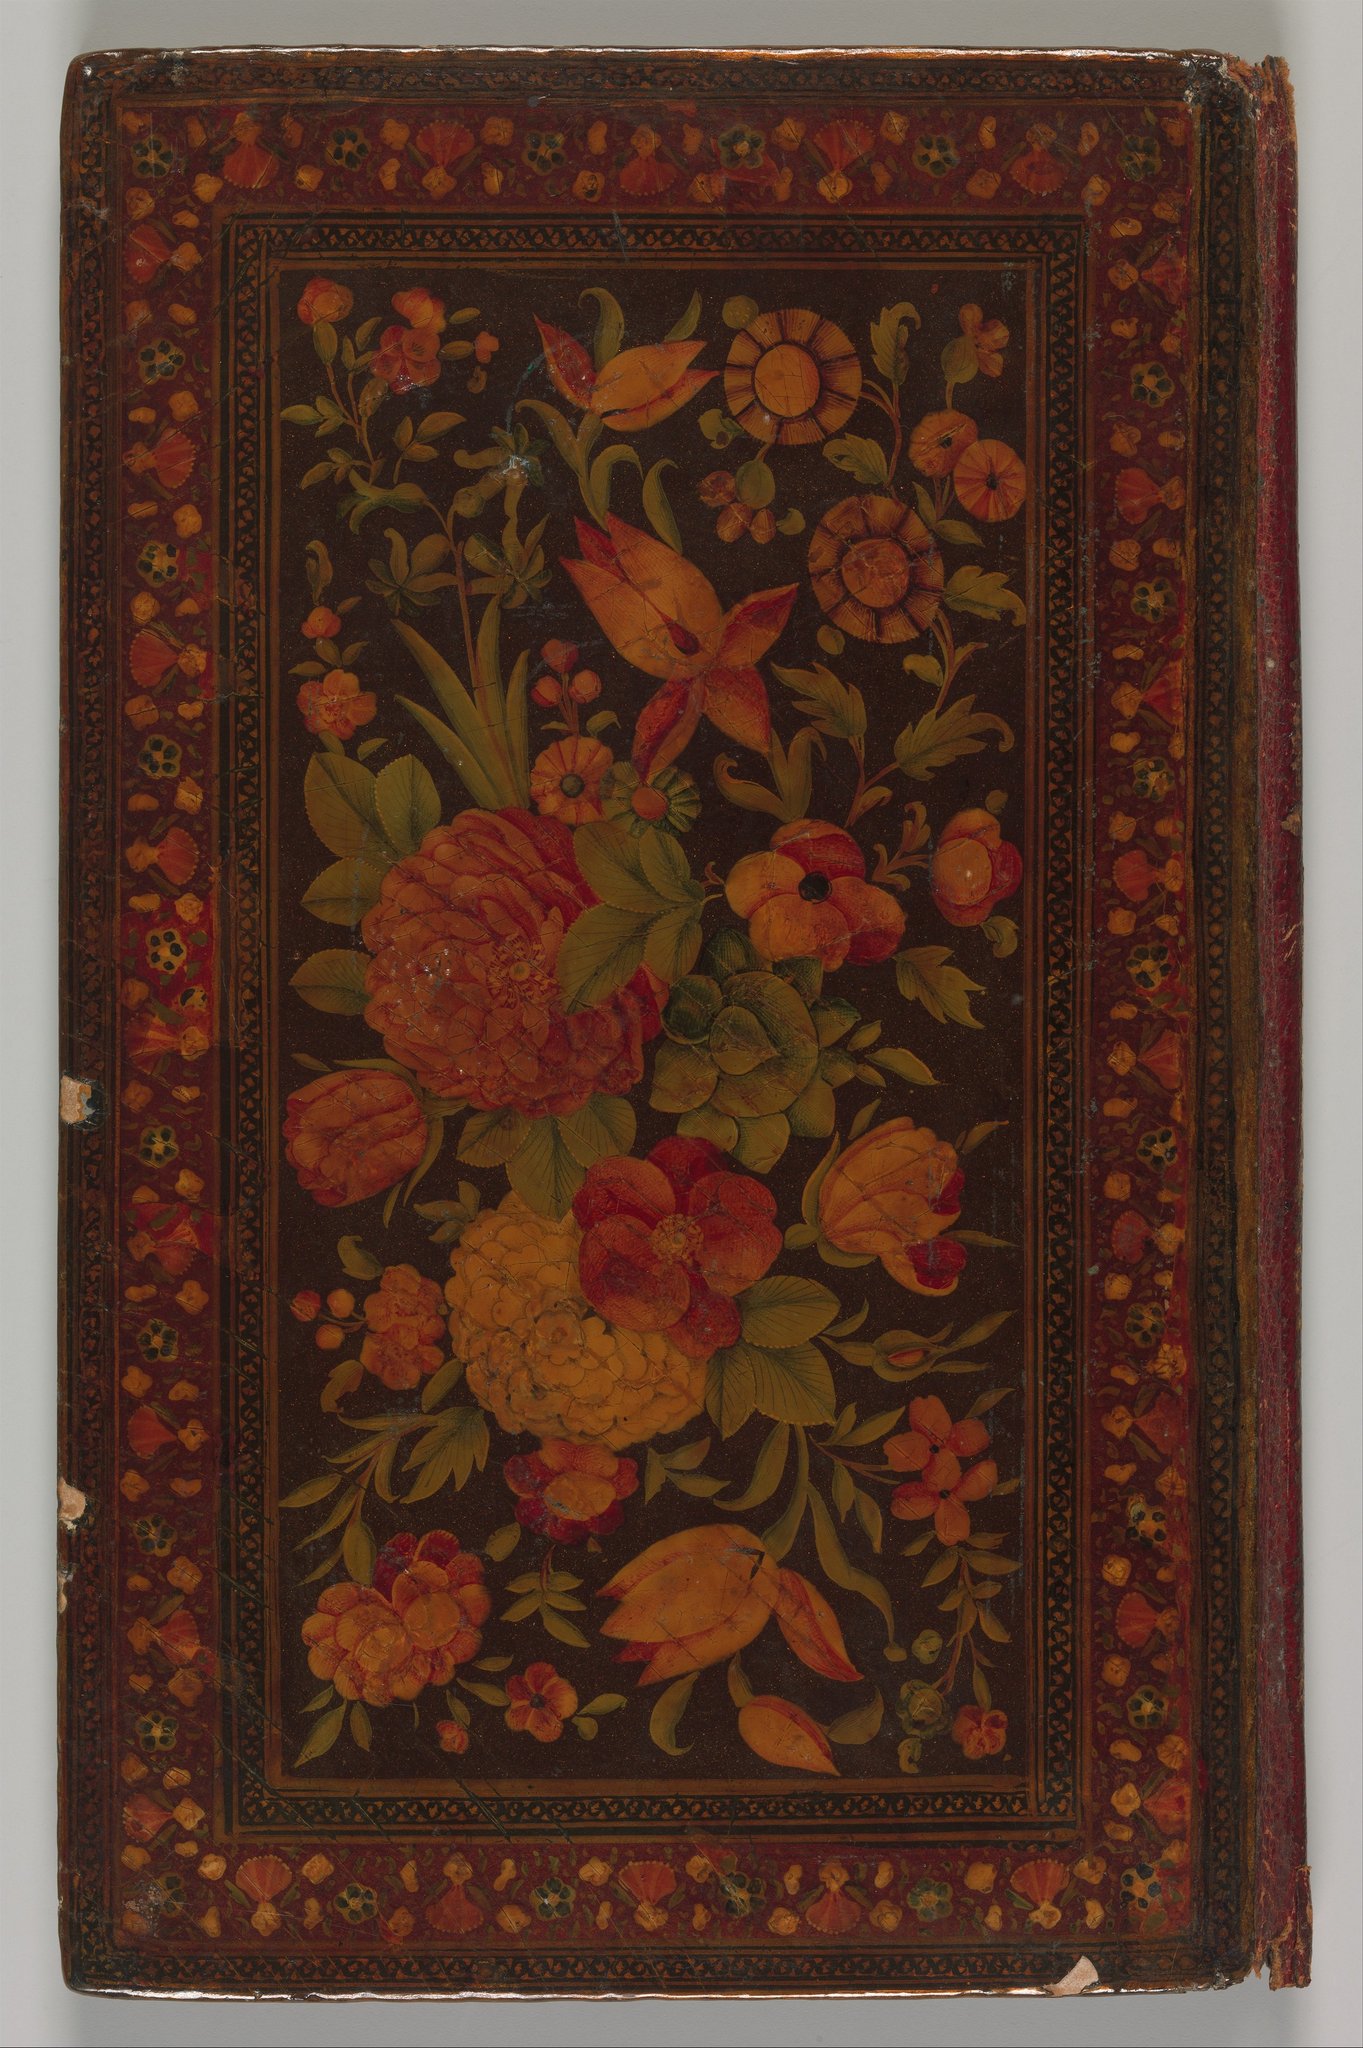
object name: non illustrated manuscript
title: Salaman u Absal of Maulana Nur al-Din 'Abd-Rahman Jami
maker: maulana nur al-din `abd al-rahman jami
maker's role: poet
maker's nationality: iranian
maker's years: 1414-1492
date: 993-1585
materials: gold, ink, paper, board, watercolor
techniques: bookbinding, lacquer, painting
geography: iran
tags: flowers